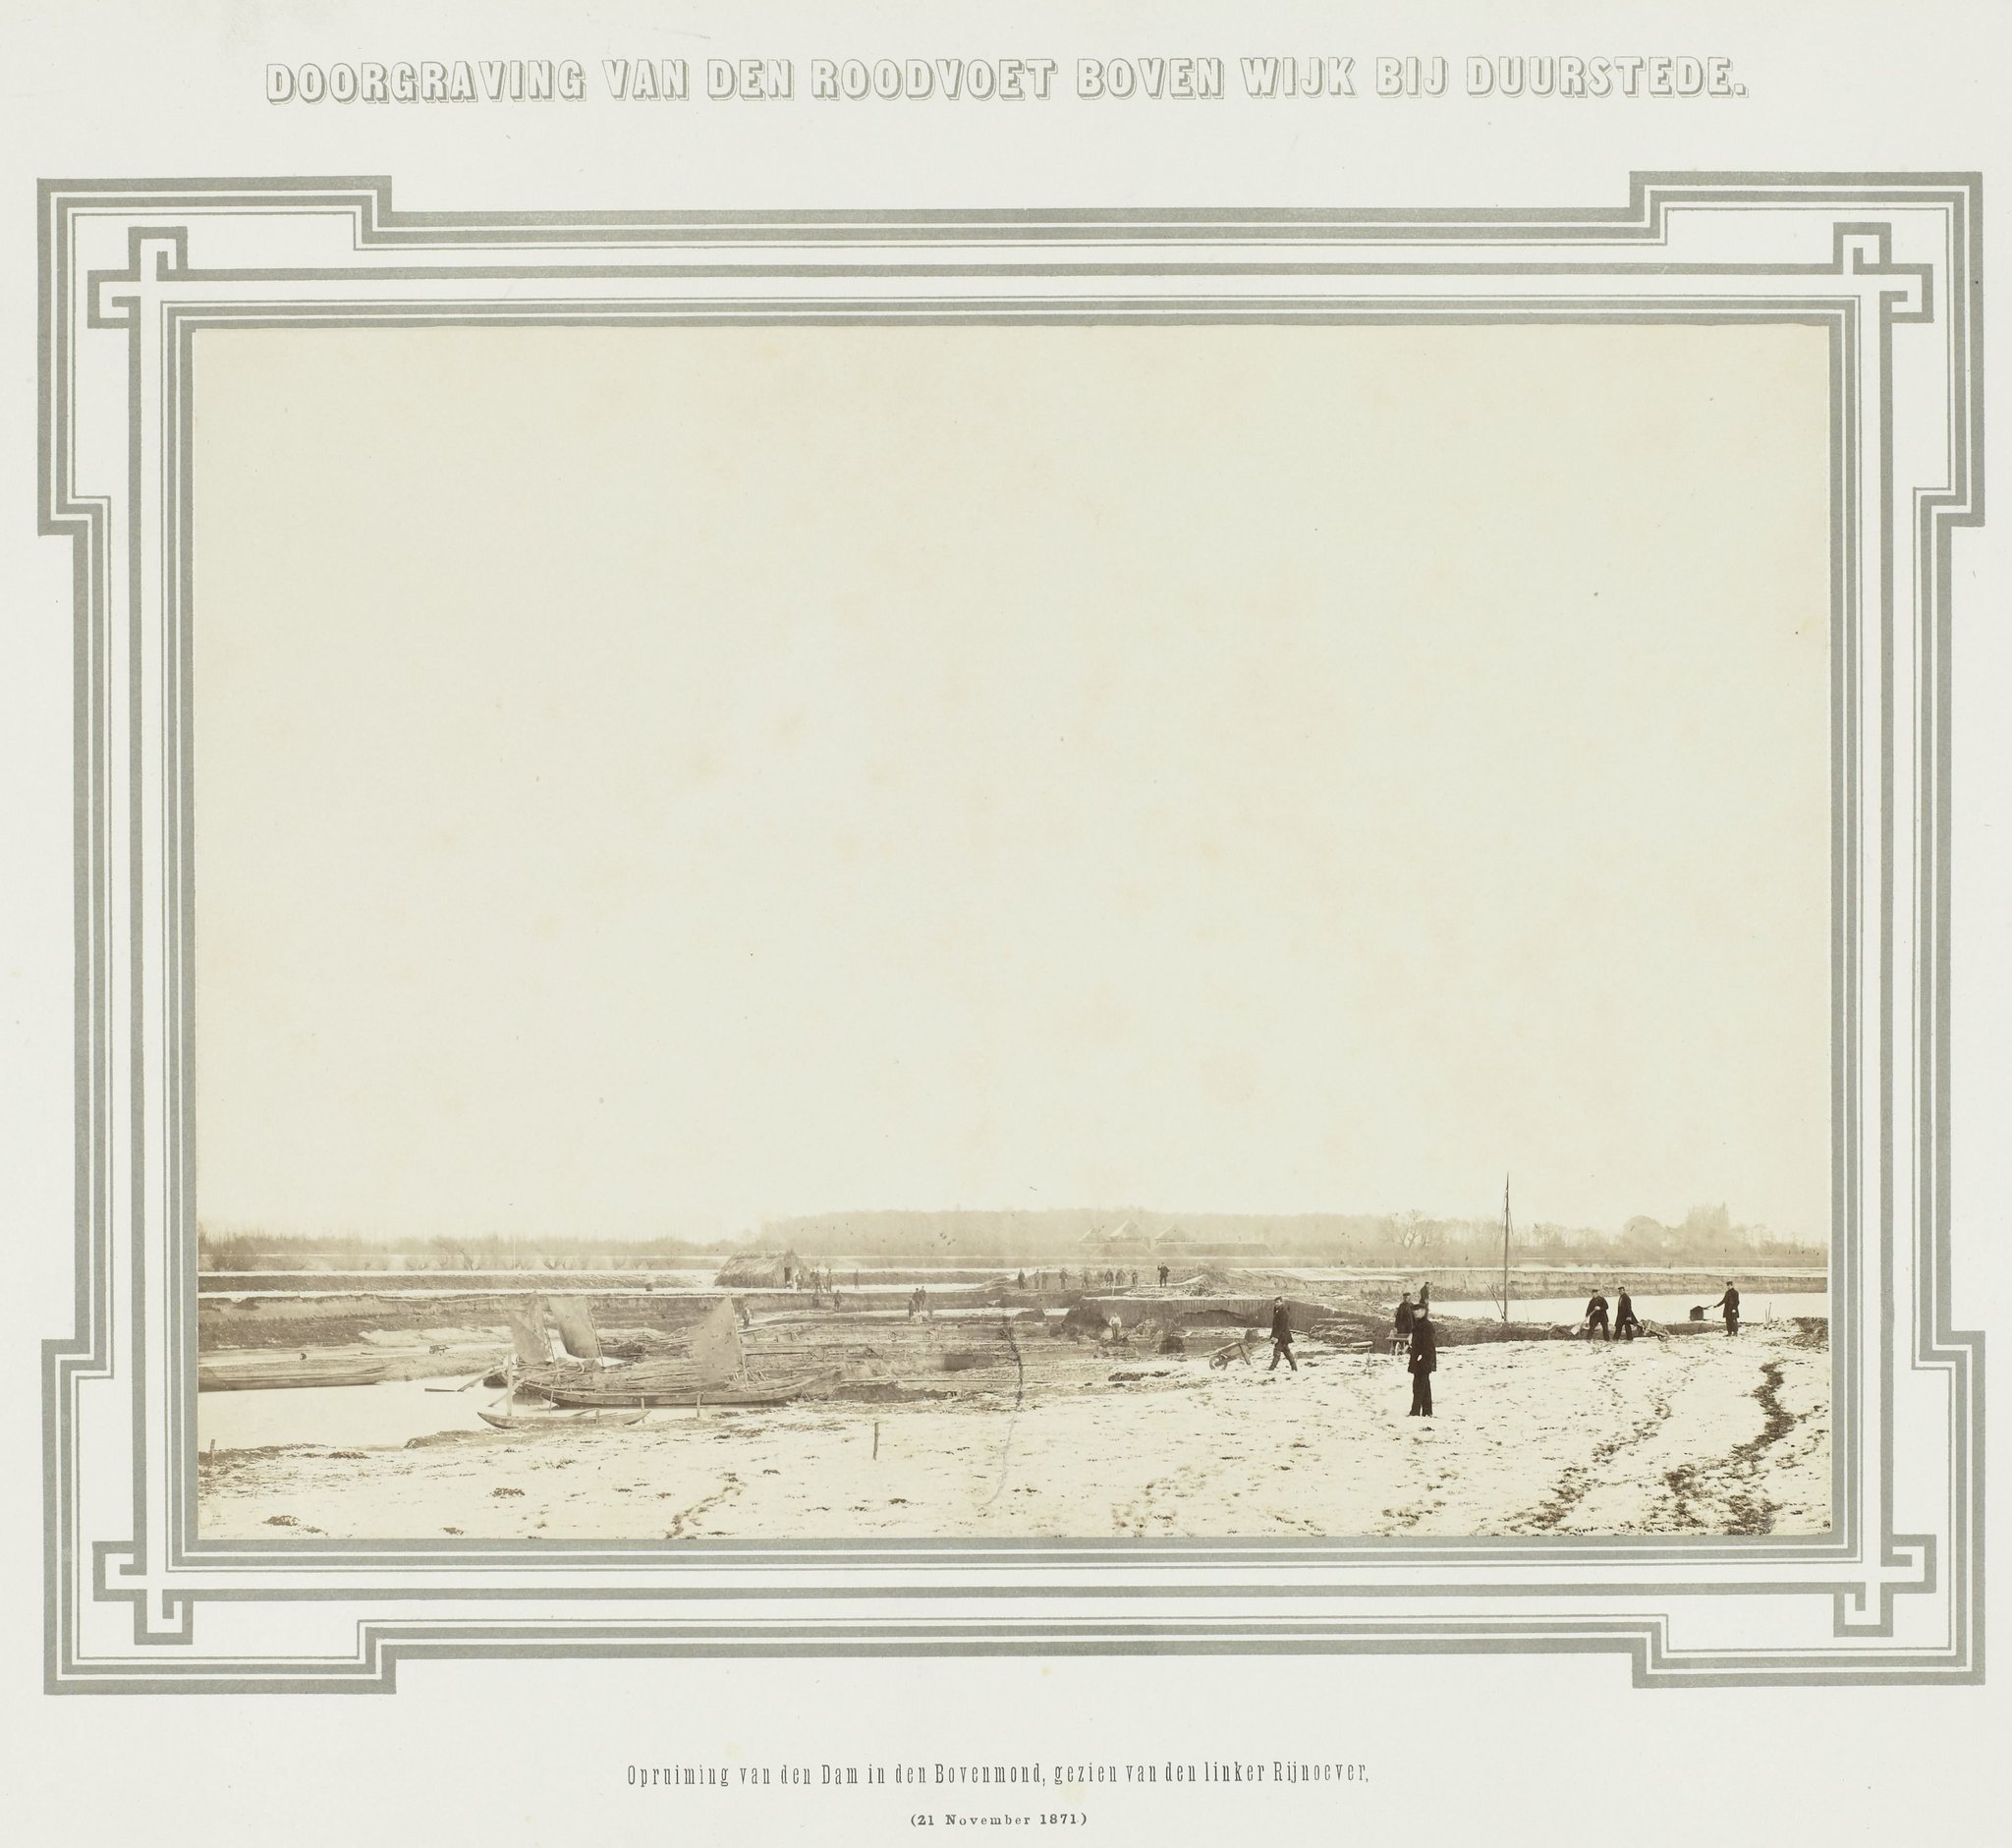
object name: photograph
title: Opruiming van den Dam in den Bovenmond, gezien van den linker Rijnoever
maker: Anonymous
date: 1871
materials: cardboard, paper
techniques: photography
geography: wijk bij duurstede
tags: wijk bij duurstede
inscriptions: date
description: Foto op karton van waterbouwkundige werkzaamheden aan een kanaal.